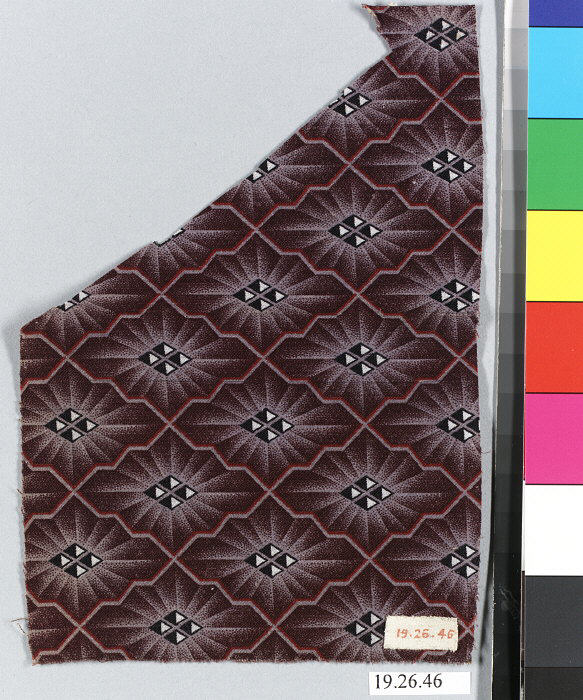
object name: sample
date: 1840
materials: cotton